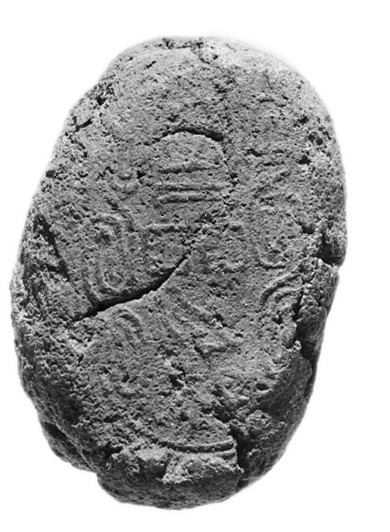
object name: sealing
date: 1981-1640 BCE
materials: clay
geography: egypt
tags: hieroglyphs